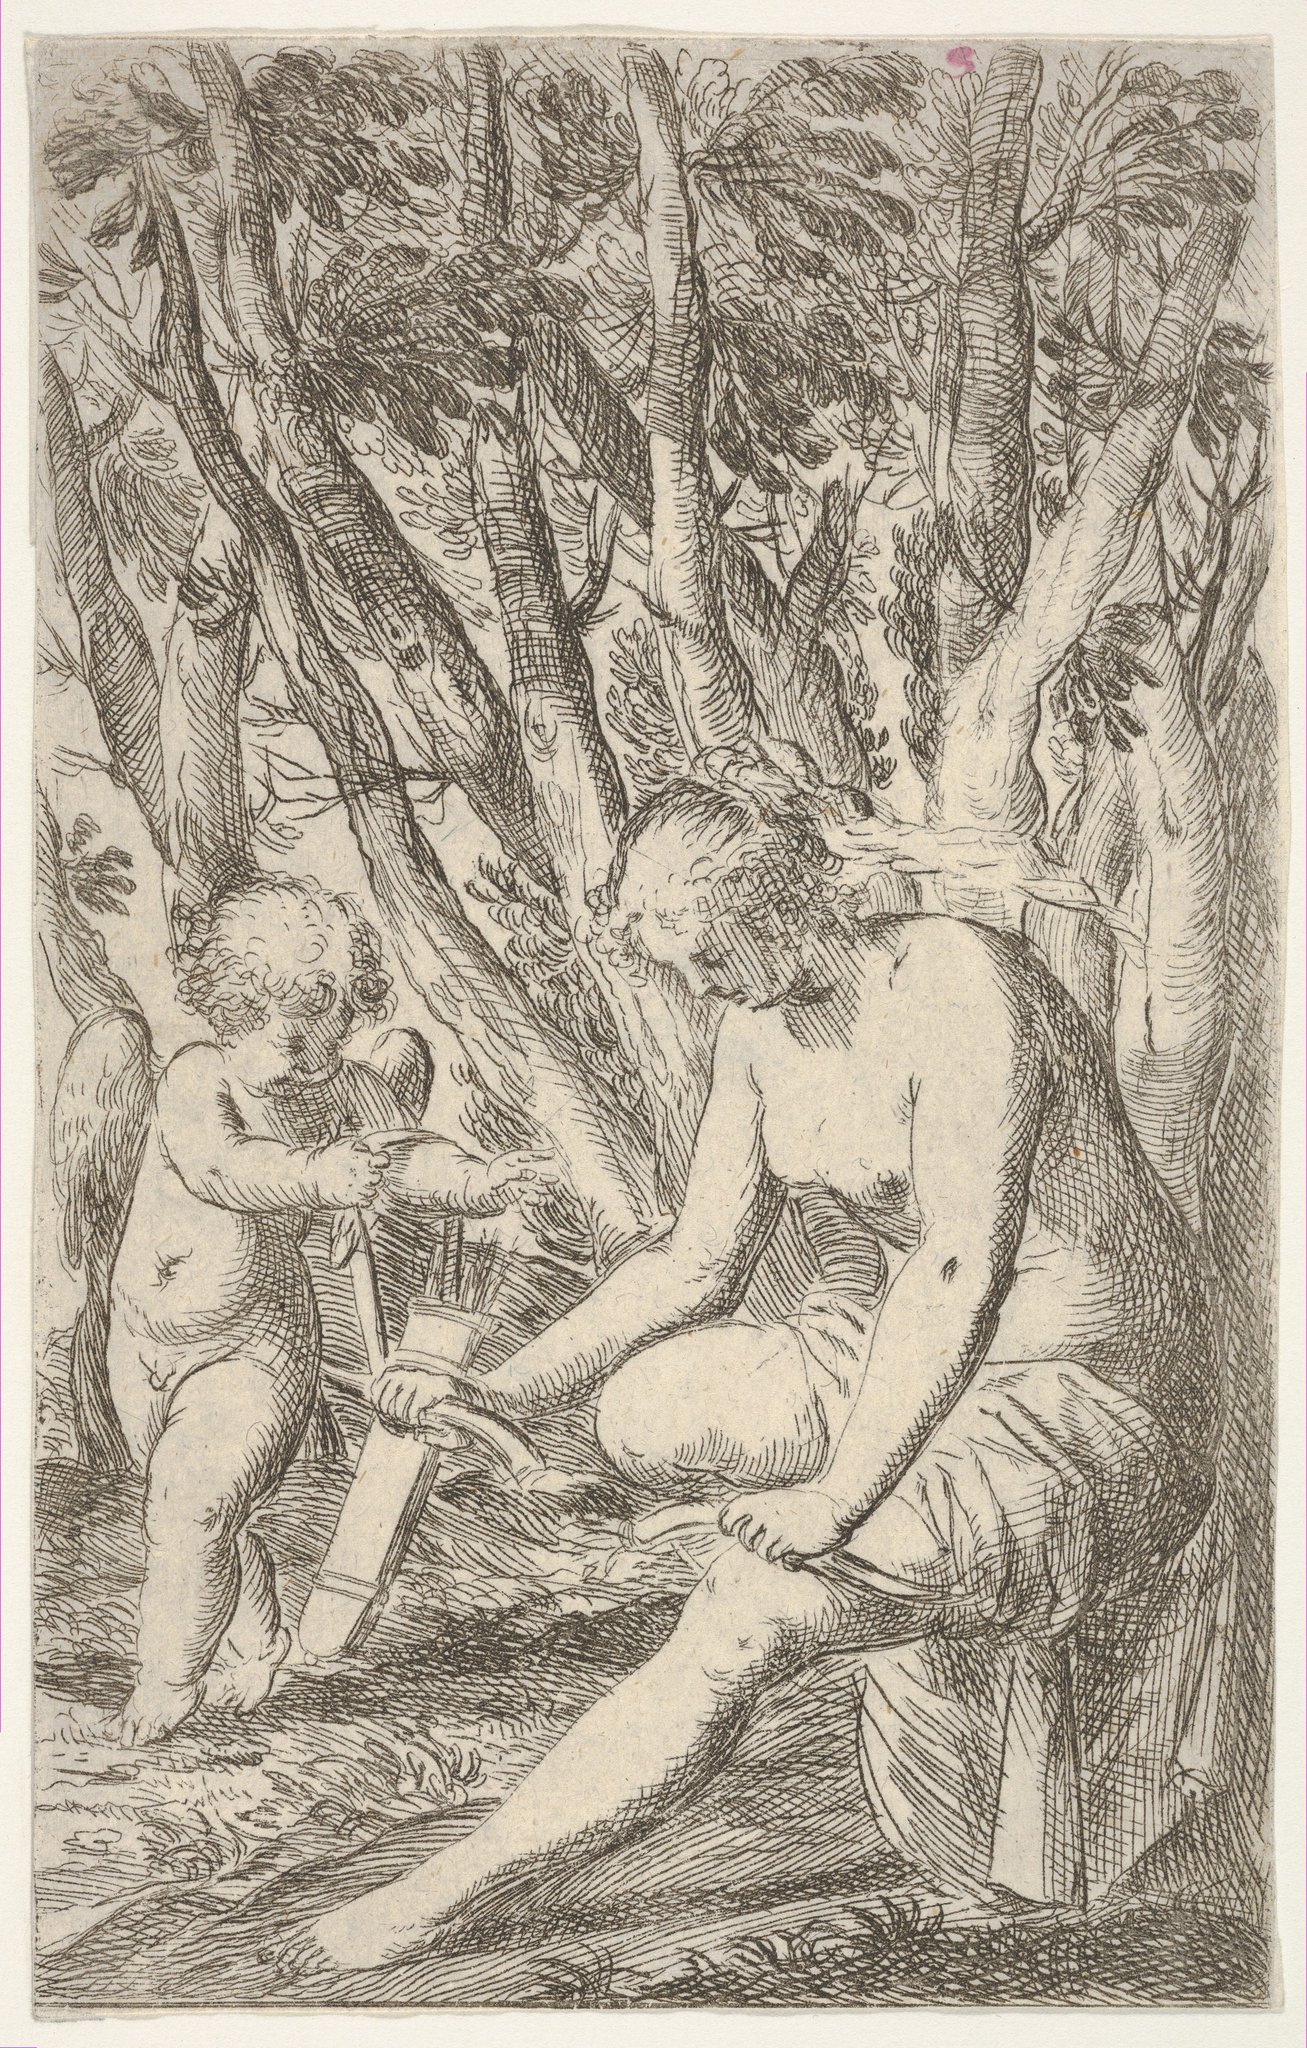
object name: print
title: Venus breaking Cupid's bow over her knee, from "Sport of Love" (Scherzi d'amore)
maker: odoardo fialetti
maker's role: artist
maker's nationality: italian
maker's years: 1573-1638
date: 1617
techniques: etching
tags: bow and arrow,cupid,venus